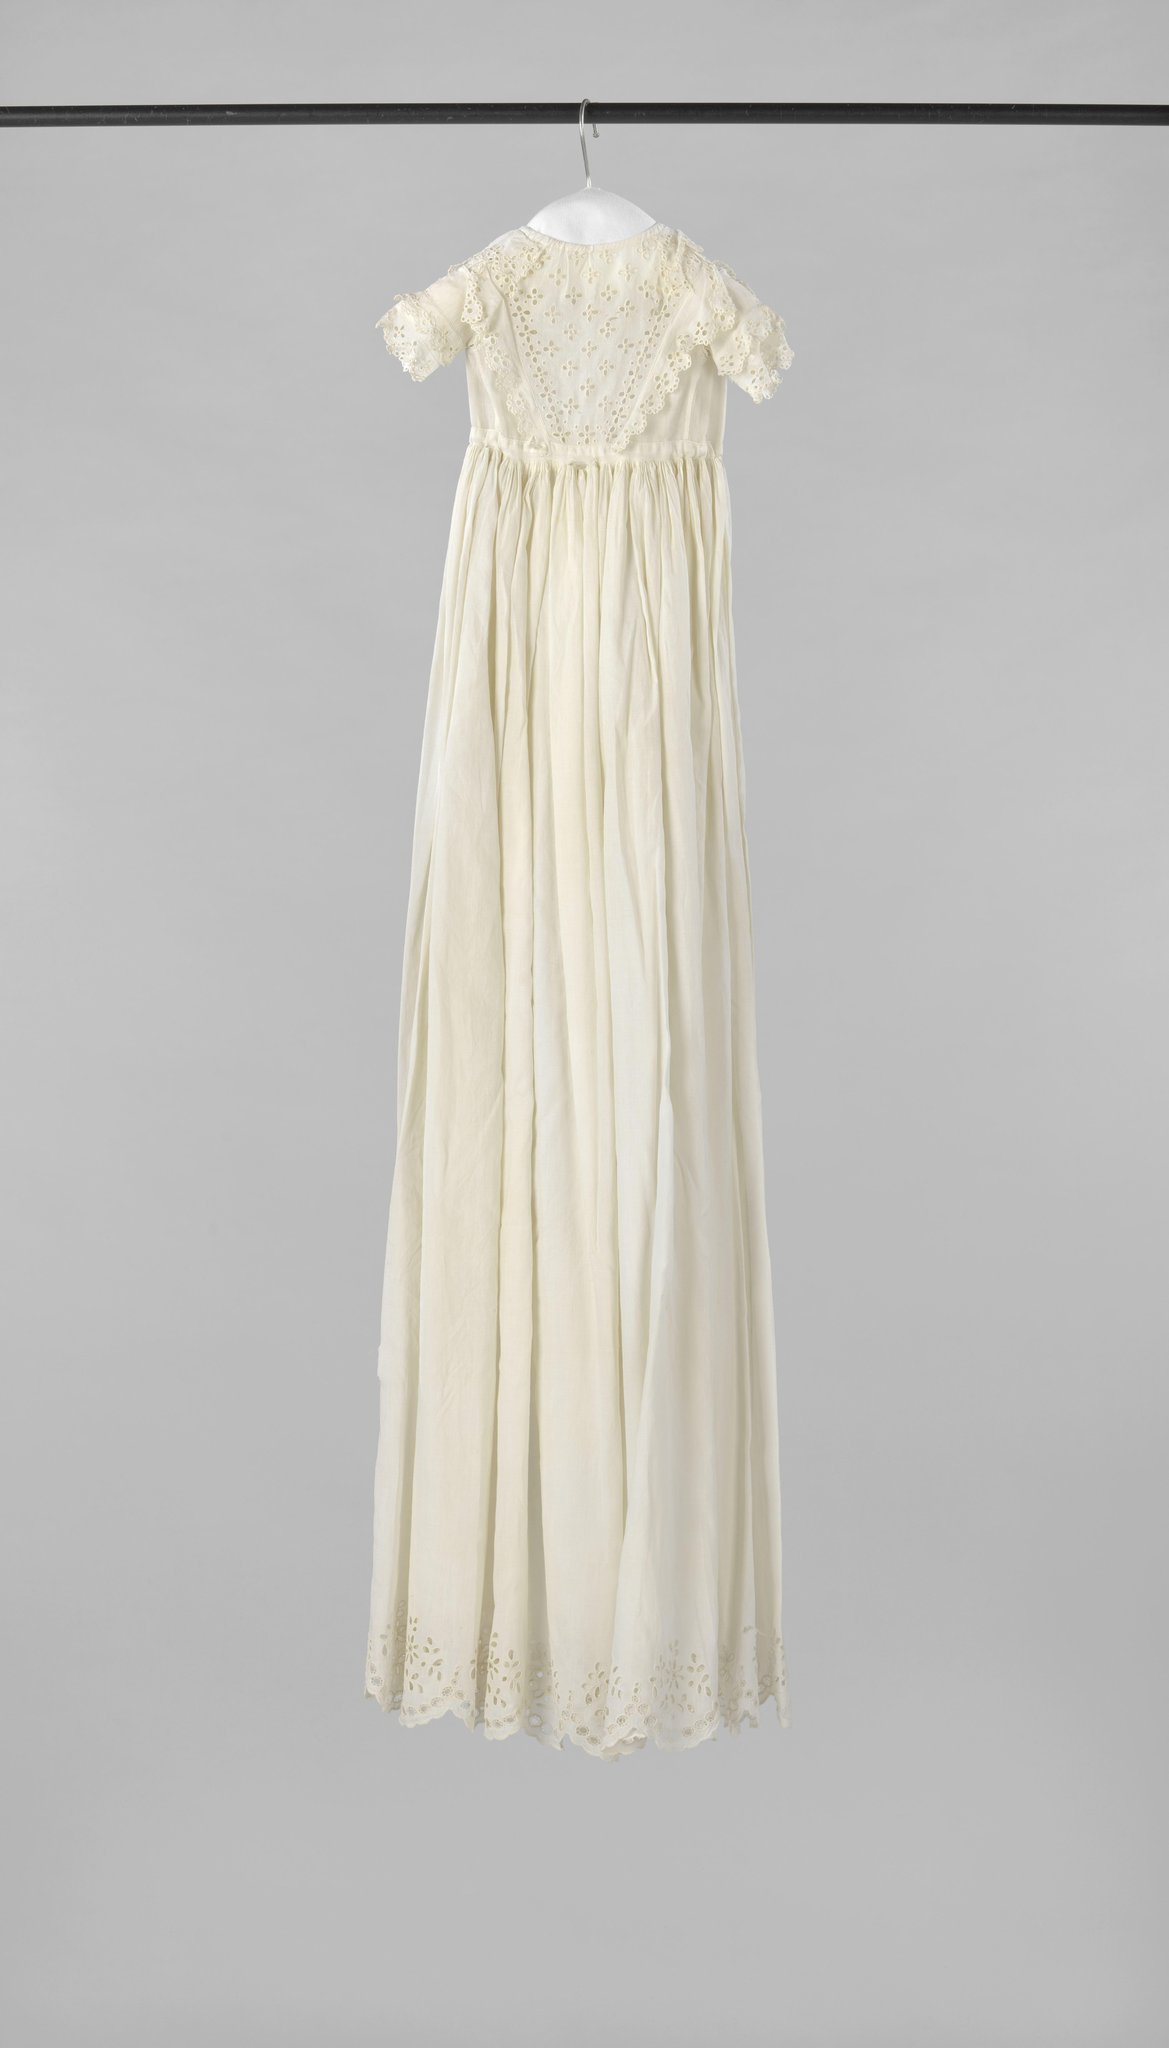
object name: baby wear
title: Babyjurk van fijn linnen met Engels borduurwerk in de mode van de Restauration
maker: Anonymous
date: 1825-1835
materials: linen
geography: netherlands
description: Babyjurk, ook wel "draagjurk" genoemd, van fijn linnen met Engels borduurwerk in de mode van de Restauration. Model: fijn aangerimpelde tweebaansrok met schulpzoom, van voren glad, vrij lang lijf met driehoekig sierstuk, waarlangs breed beginnende vleugelstroken; achter, aangerimpelde panden aan een schouderbies en ook met vleugelstroken. Korte afgebiesde mouw. Ajour borduurwerk van halfronde schulpen met nulletjes, waarboven tak met margieten en bladwerk. Lijf en stroken met sterren. Nederland,ca.1825-1835.